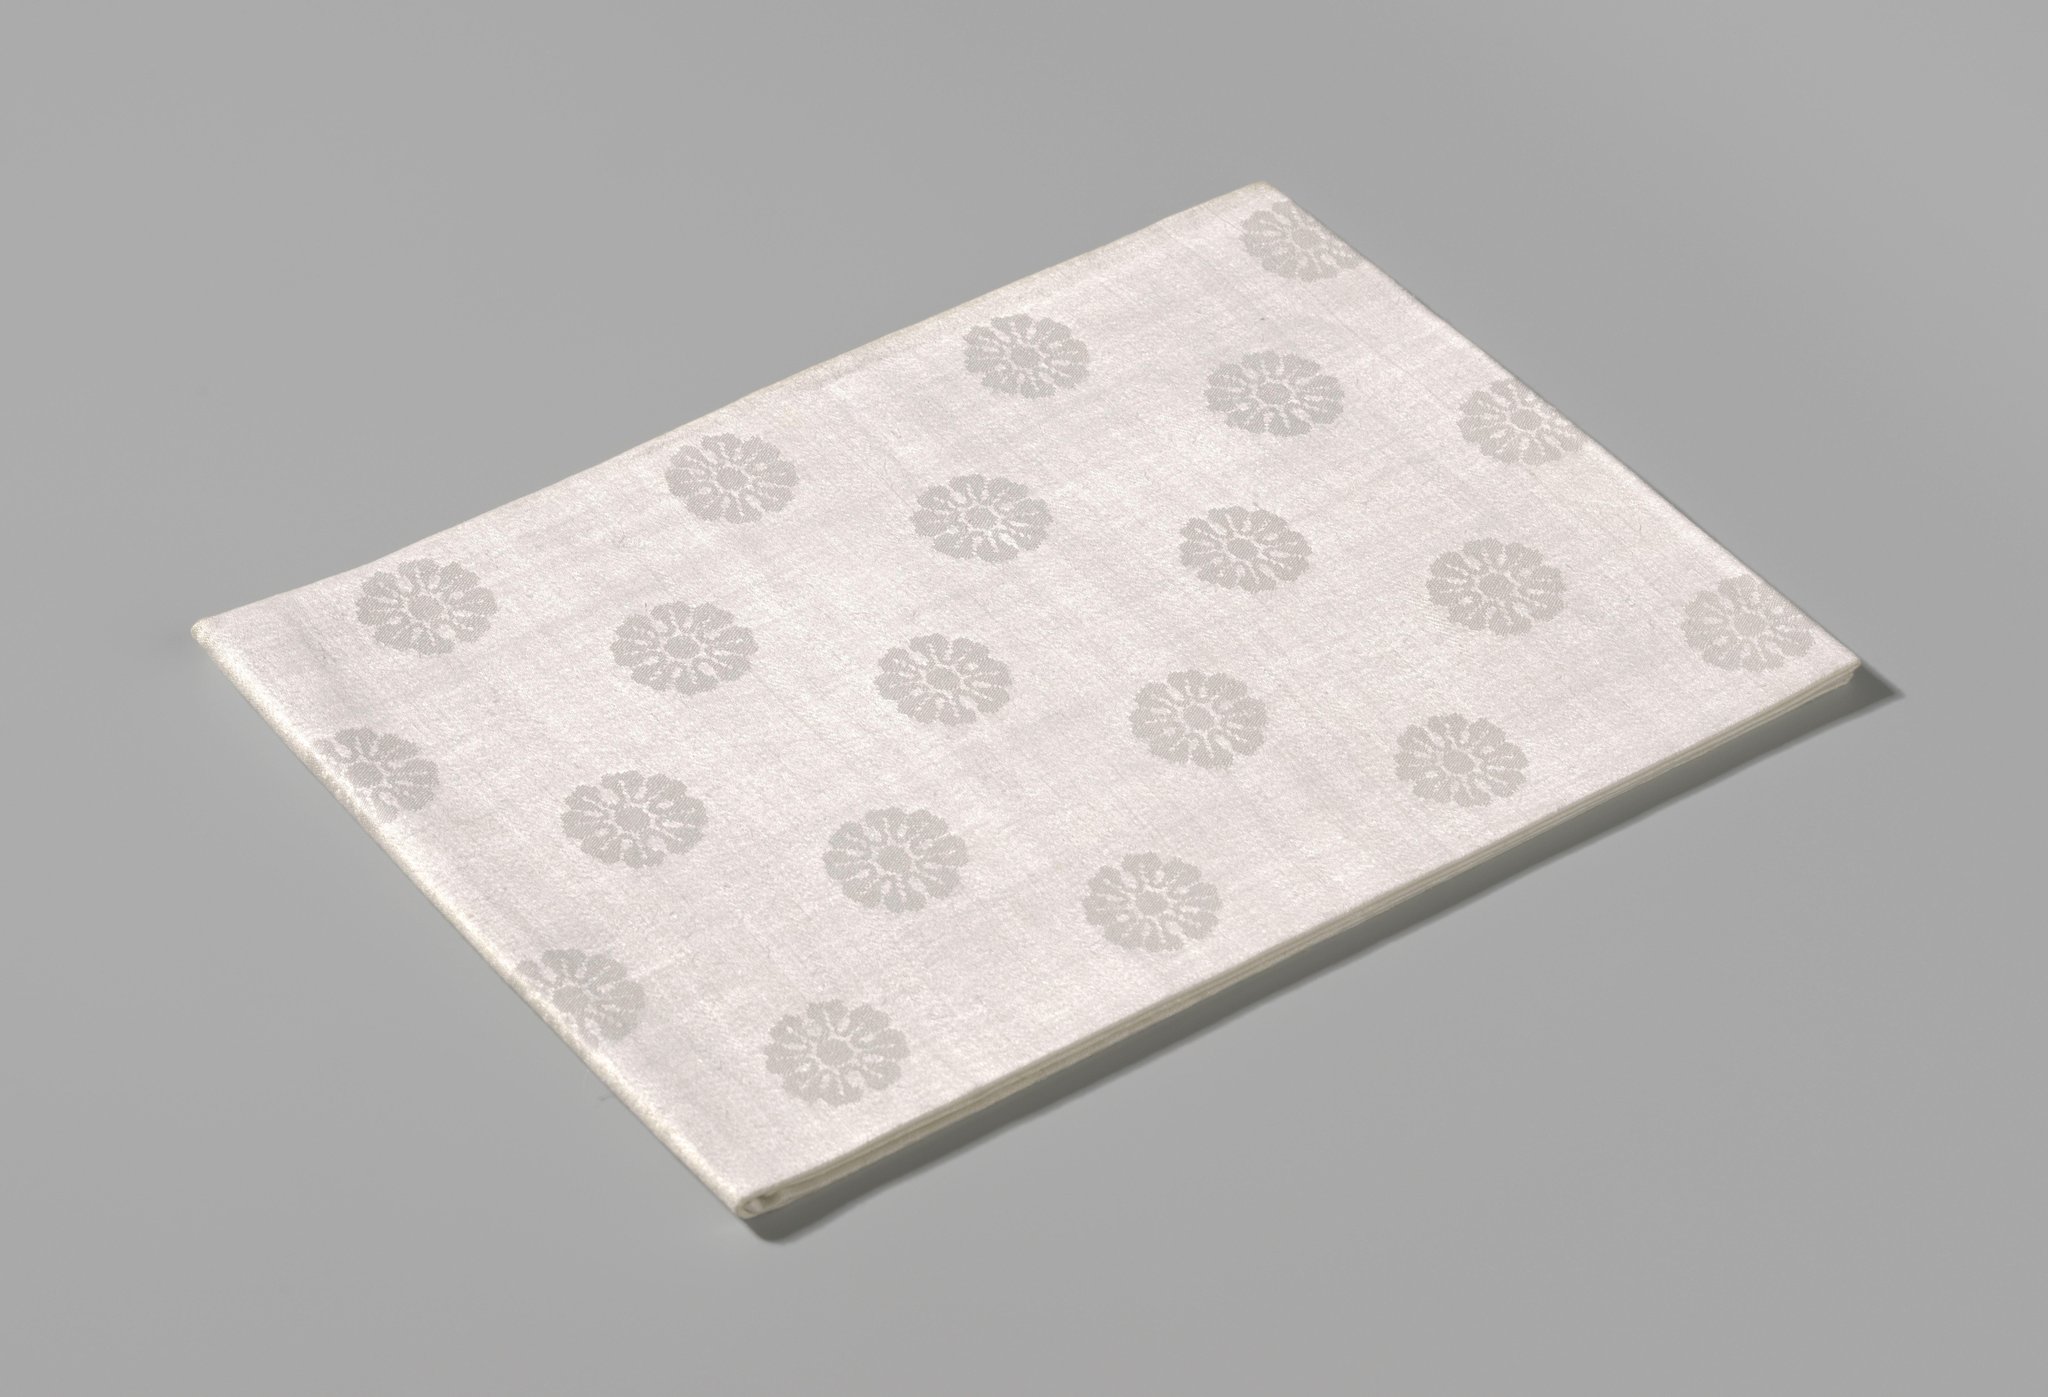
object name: napkin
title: Servet van linnendamast met een bloempatroon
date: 1849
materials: linen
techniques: damask, weave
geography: northern netherlands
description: Servet van linnendamast. Het veld heeft verspringende rijen rozetten en de randen bloemen en acanthusbladeren. De hoeken hebben een vaas met vruchten. Het servet is gemerkt: HW36 1849. Het servet hoort bij dertien servetten (BK-1980-377-A t/m BK-1980-377-N).